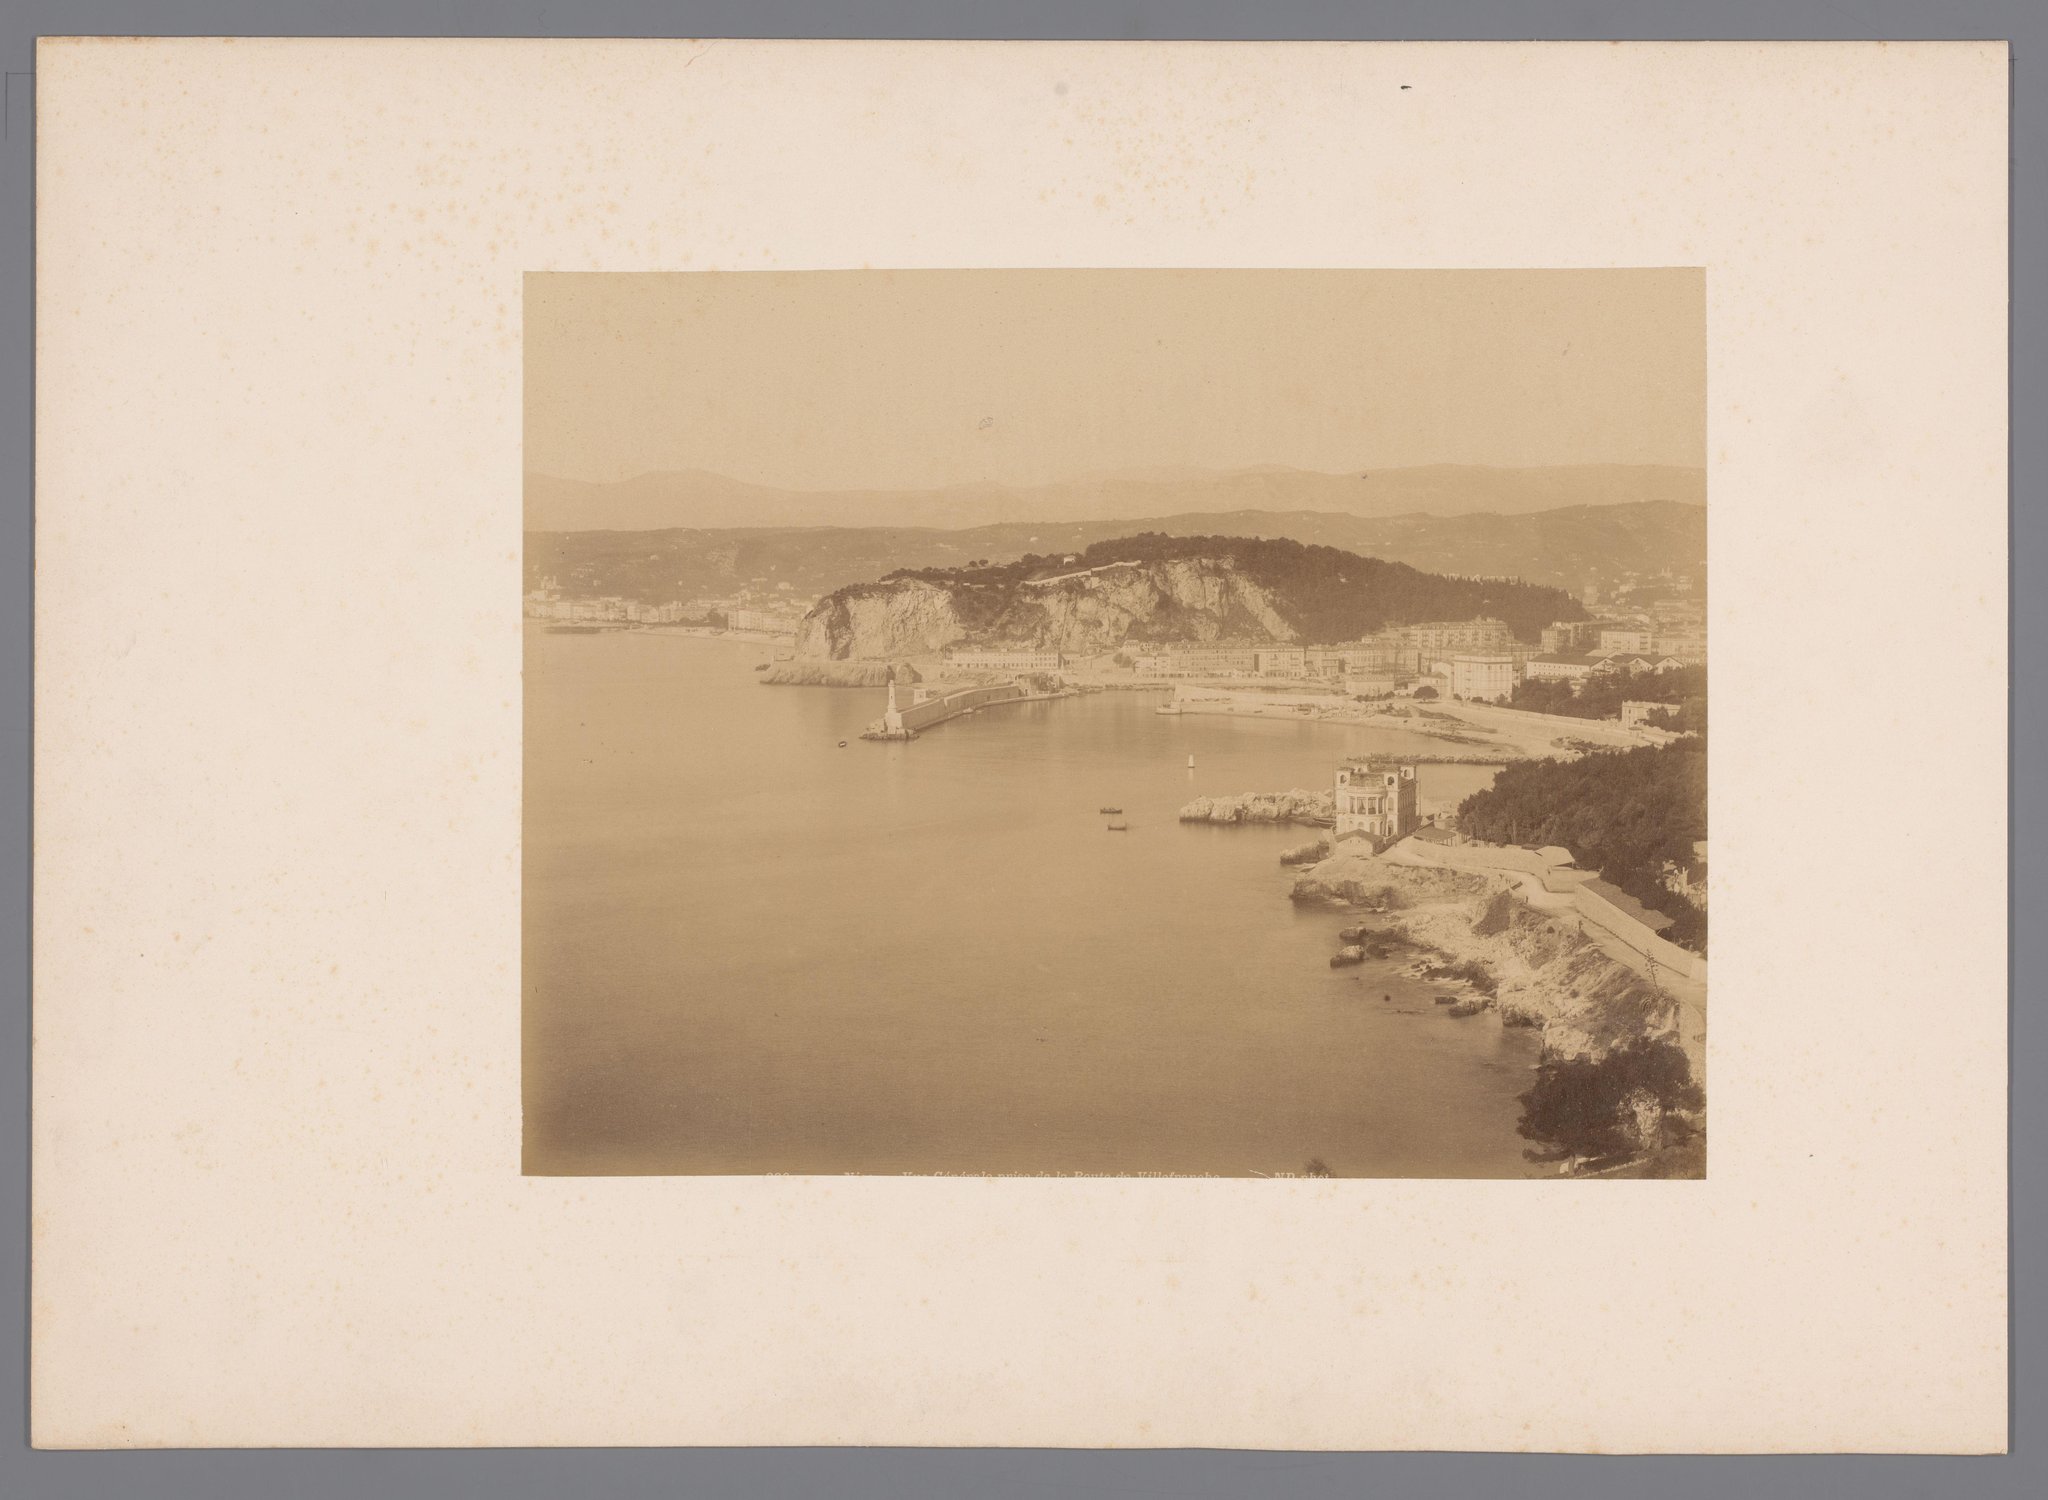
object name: photograph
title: Gezicht op de baai van Nice, Frankrijk ('Nice - Vue prise de la Route de Villefranche')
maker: étienne neurdein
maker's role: publisher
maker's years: 1832-1918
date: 1883-1888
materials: cardboard, paper, photographic support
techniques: albumen print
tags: nice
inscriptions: inscription: ‘ND Phot.’, inscription: ‘[?] Nice [?] - Vue Générale prise de la Route de Villefranche [?]’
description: Gezicht op de baai van Nice, Frankrijk ('Nice - Vue prise de la Route de Villefranche').